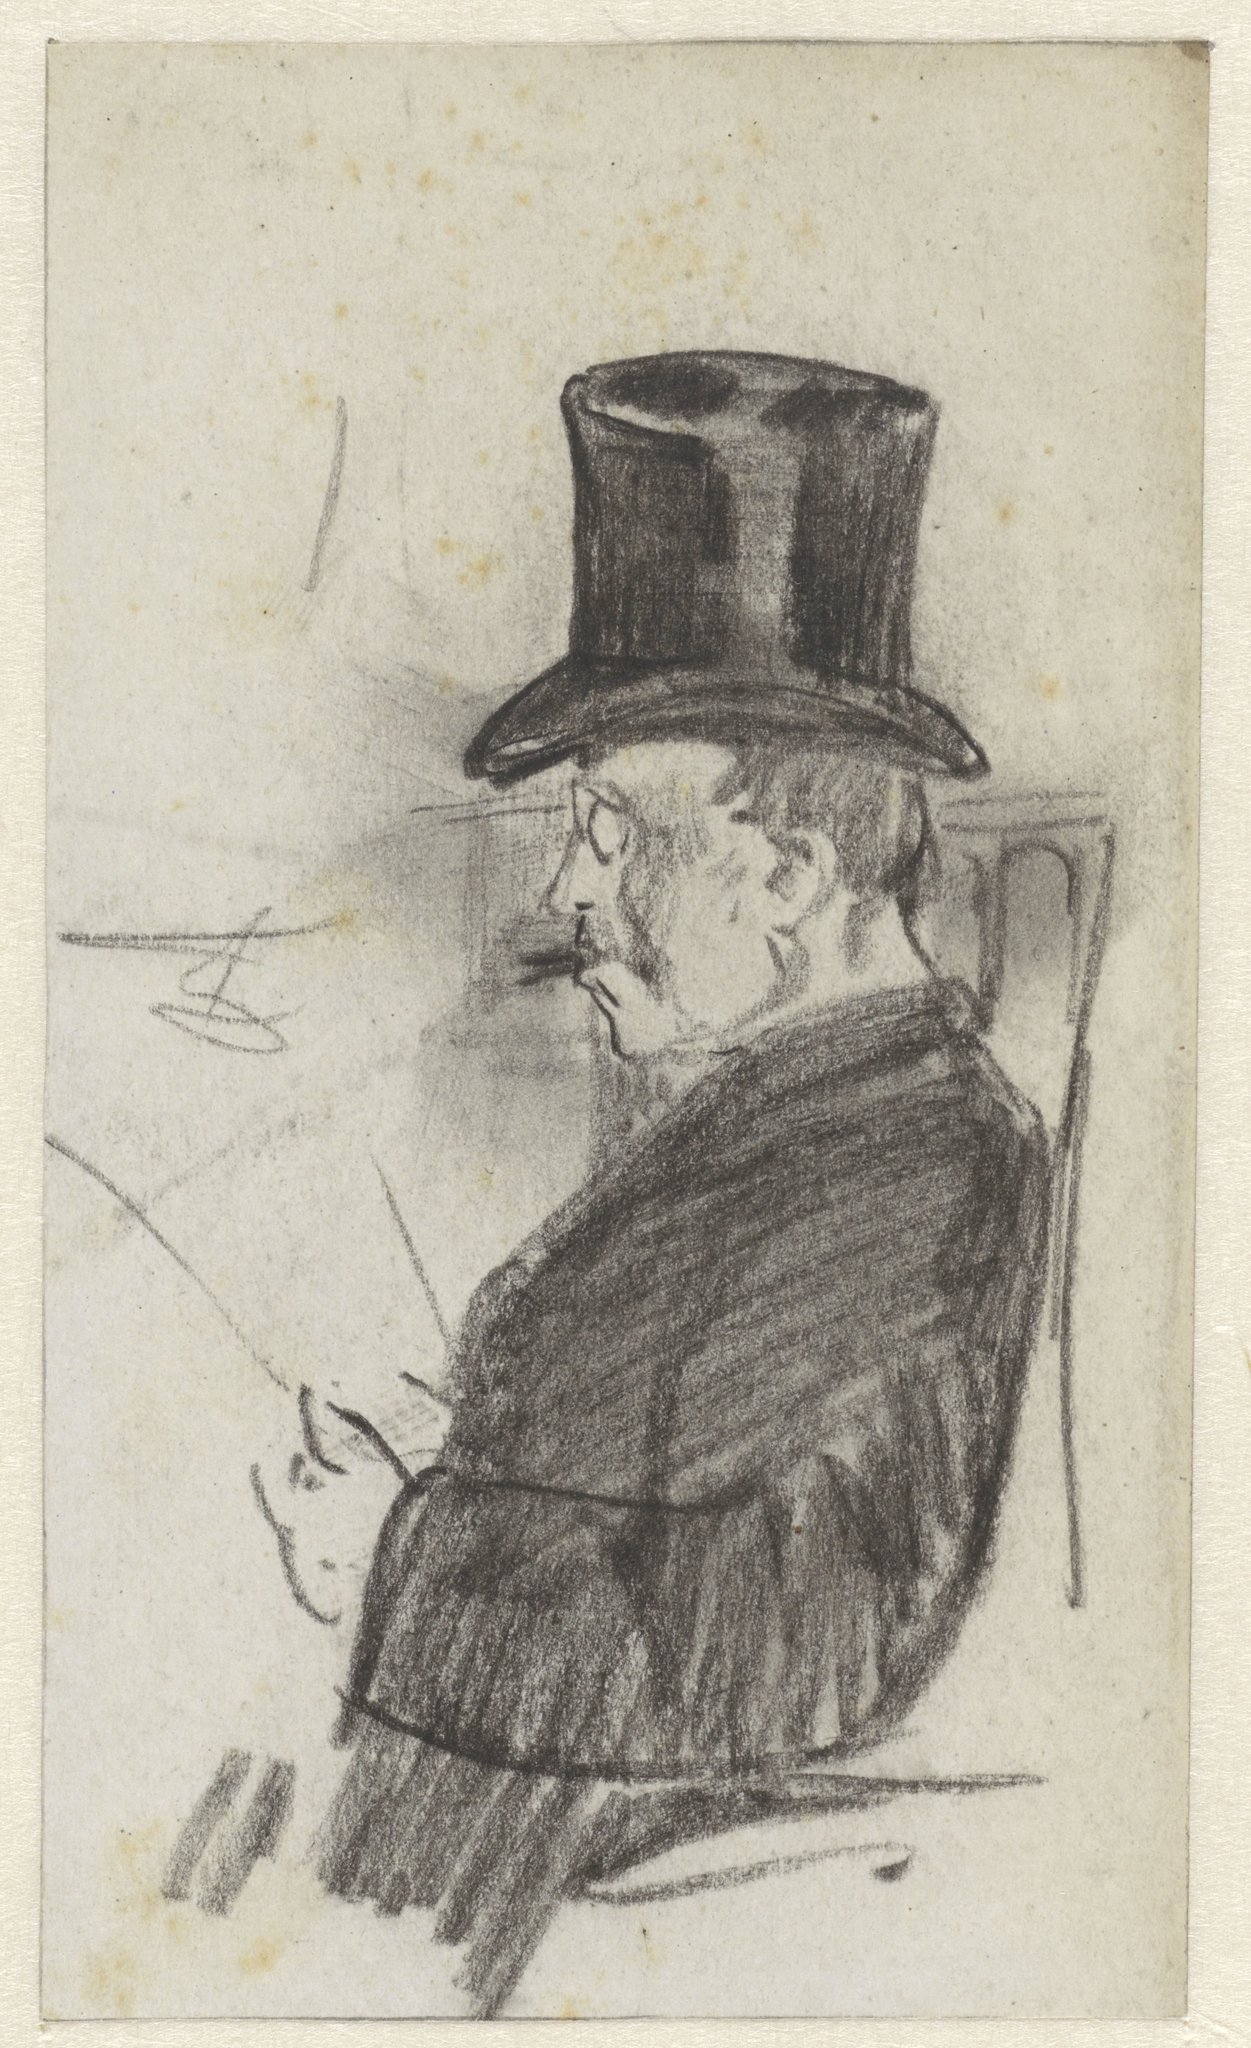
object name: drawing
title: Krantenlezer met hoge hoed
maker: jac van looij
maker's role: draughtsman, painter, print maker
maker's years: 1855-1930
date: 1865-1930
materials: chalk, paper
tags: reading